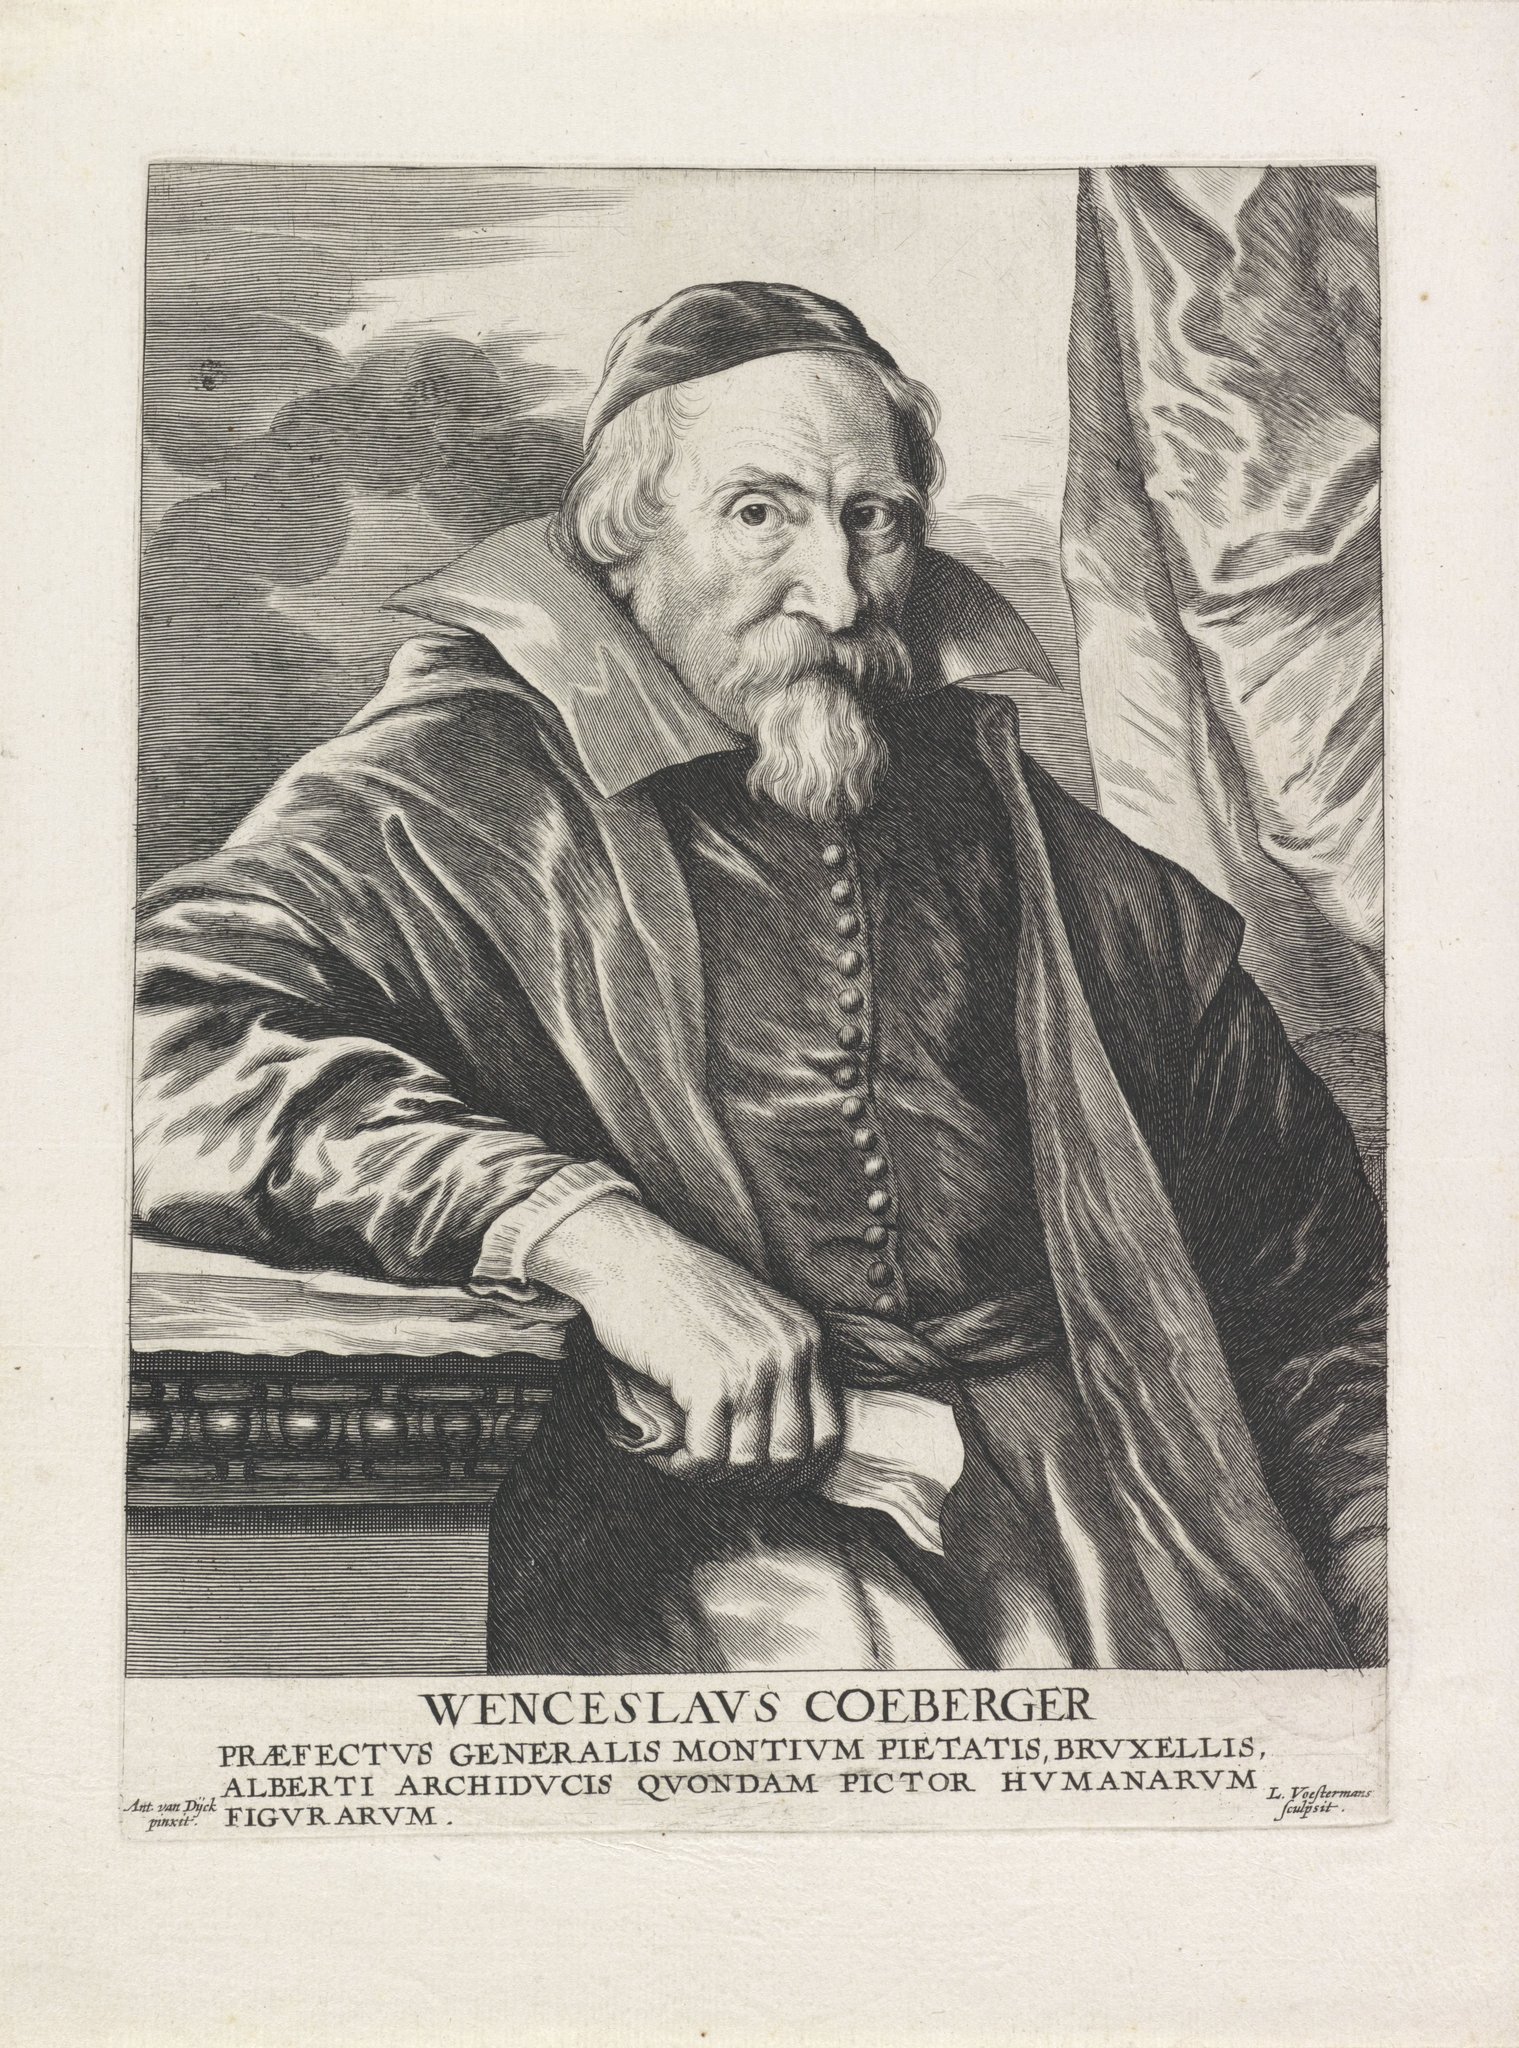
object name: print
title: Portret van Wenzel Coebergher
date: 1646-1675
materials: paper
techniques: engraving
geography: antwerp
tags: brussels, painter, draughtsman, wenzel coebergher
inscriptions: collector's mark: Lugt 240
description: Prent gebruikt voor: Icones principum, virorum doctorum, pictorum, chalcographorum, statuariorum nec non amatorum pictoriae artis numero centum ab Ant. van Dyck ad vivum expressae ejusque sumptibus aeri incisae. Antwerpen: Gillis Hendricx, [1645-1646].